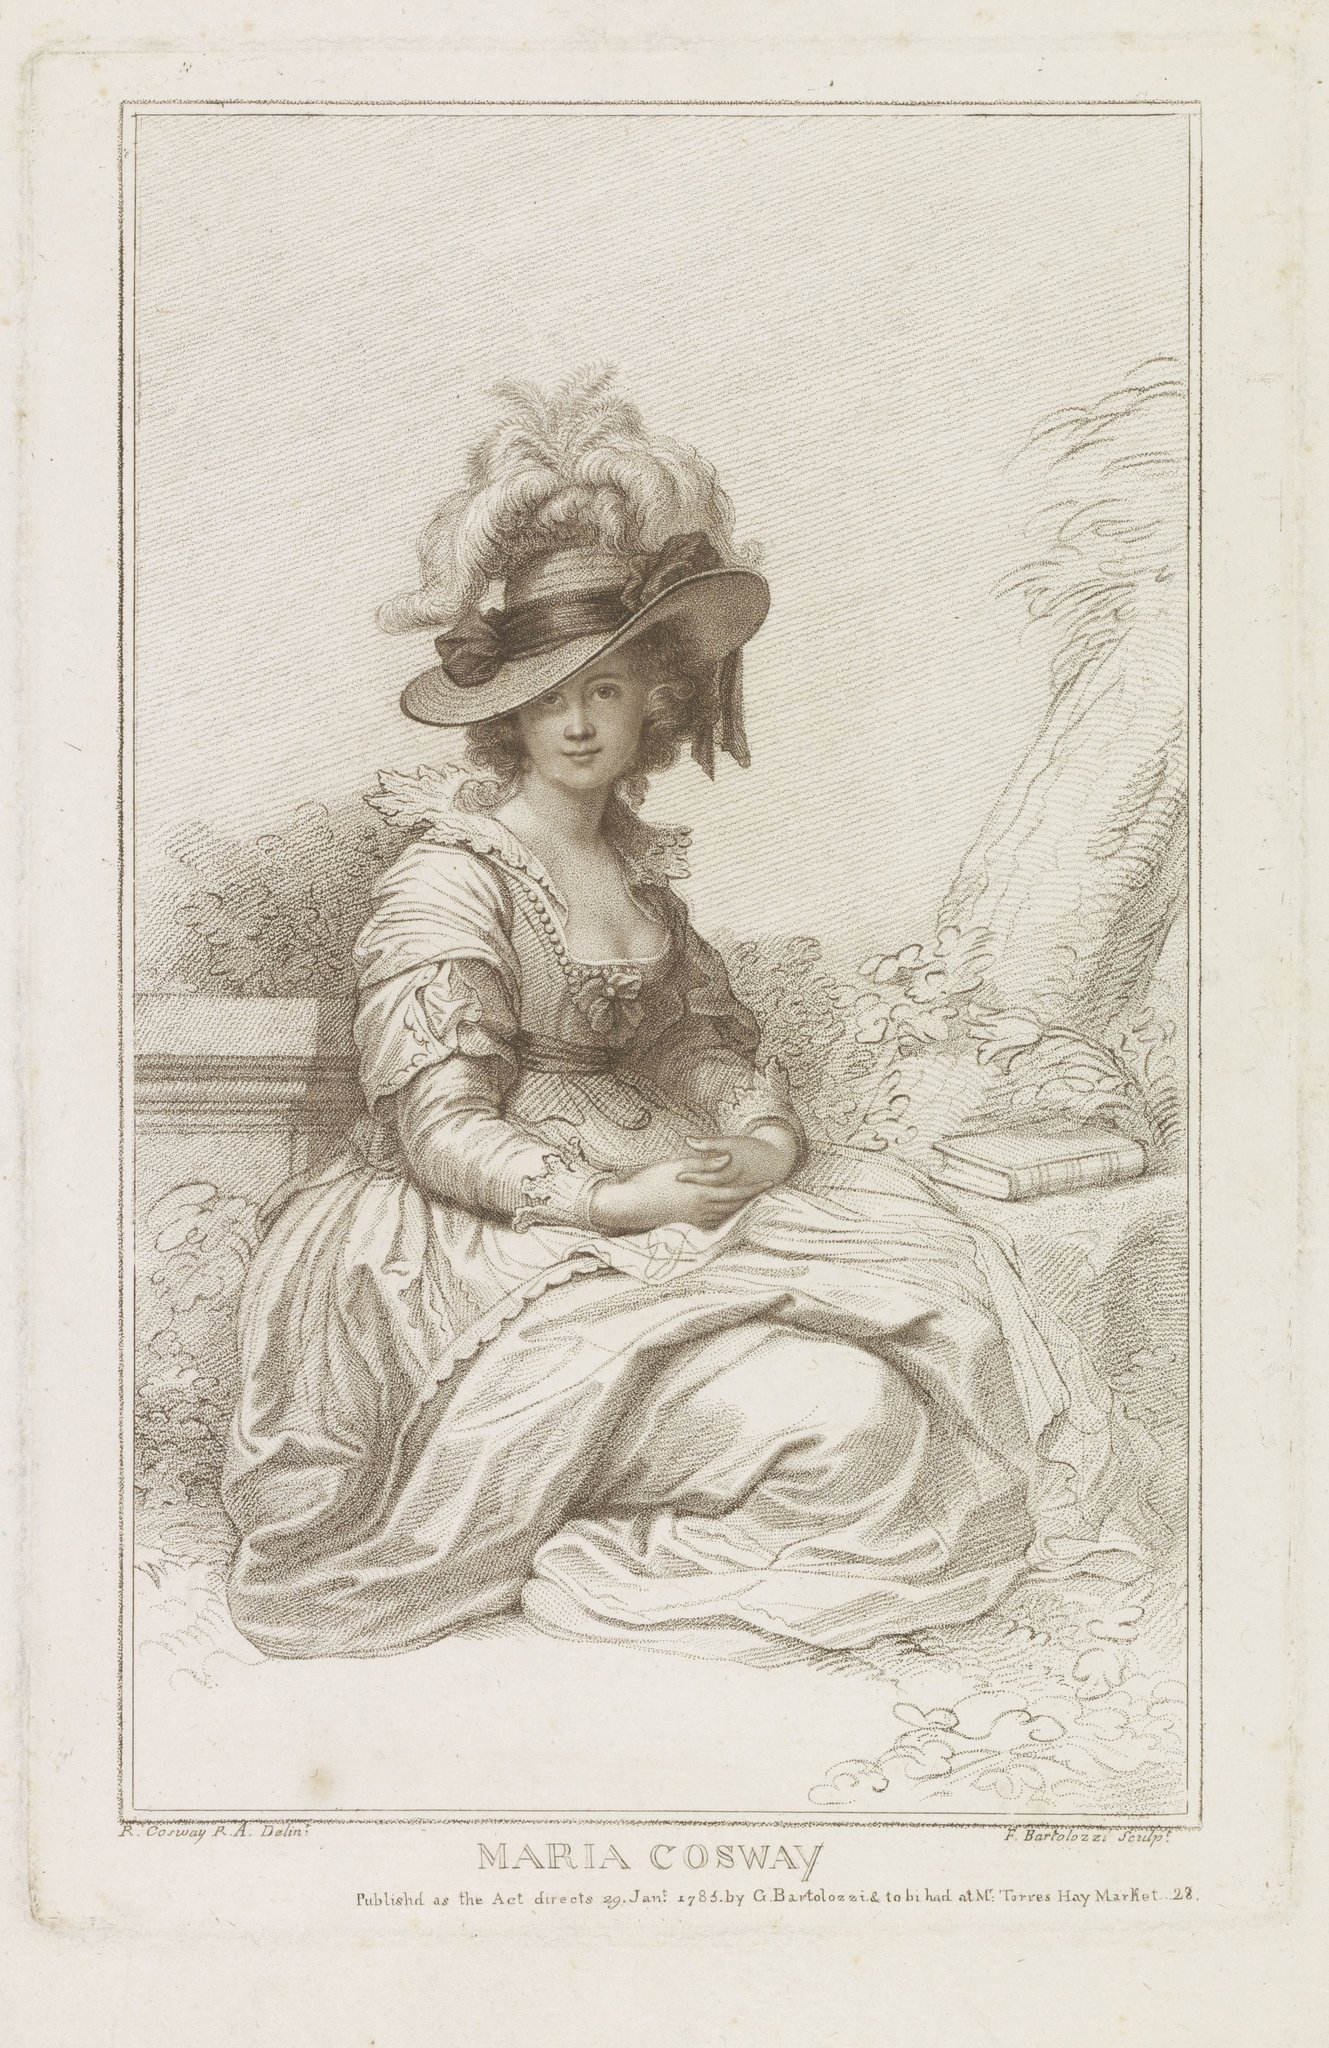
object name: print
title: Portret van Maria Cosway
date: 1785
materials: paper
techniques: etching, engraving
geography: london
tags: painter, print maker, draughtsman, maria hadfield, historical persons, portrait, self-portrait of artist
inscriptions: collector's mark: Lugt 2165